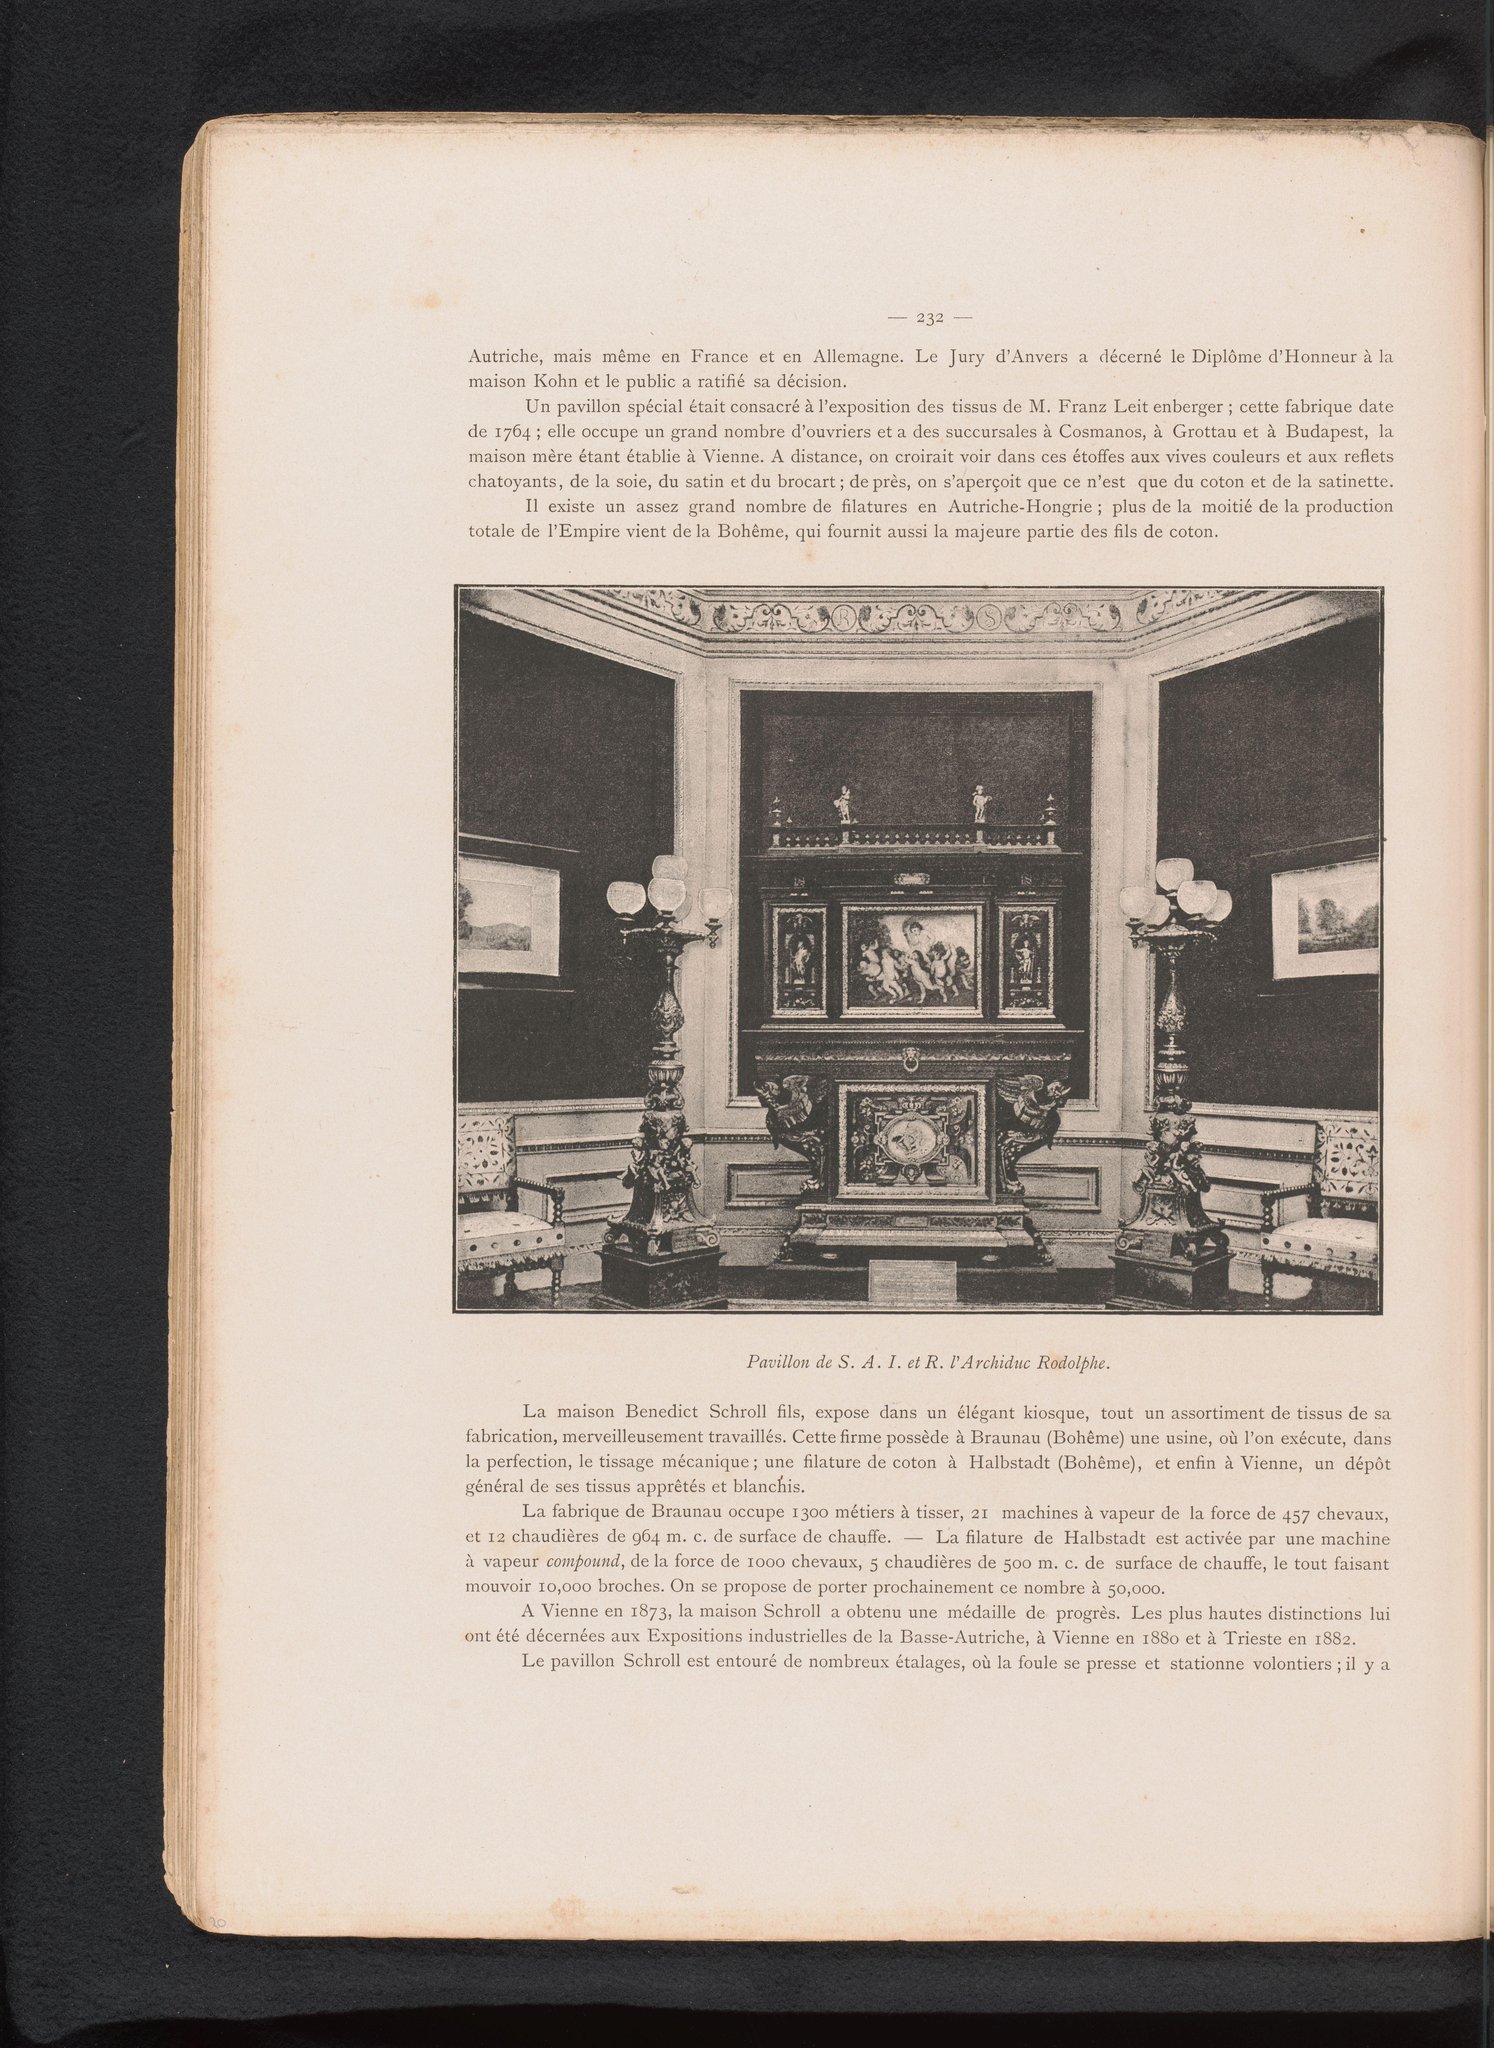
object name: photomechanical print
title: Pavillon de S. A. I. et R. l'Archiduc Rodolphe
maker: Anonymous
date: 1880-1885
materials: paper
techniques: autotype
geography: antwerp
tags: world fair, world exhibition, antwerp